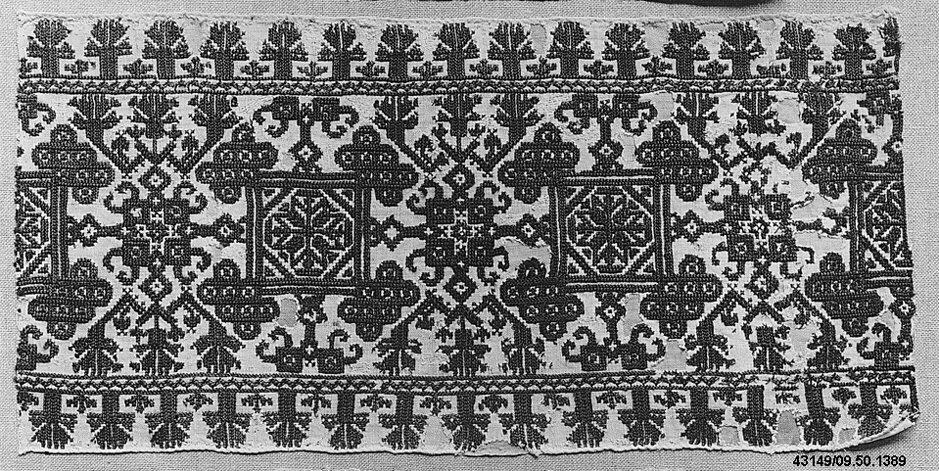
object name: band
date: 1501-1700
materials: linen, silk